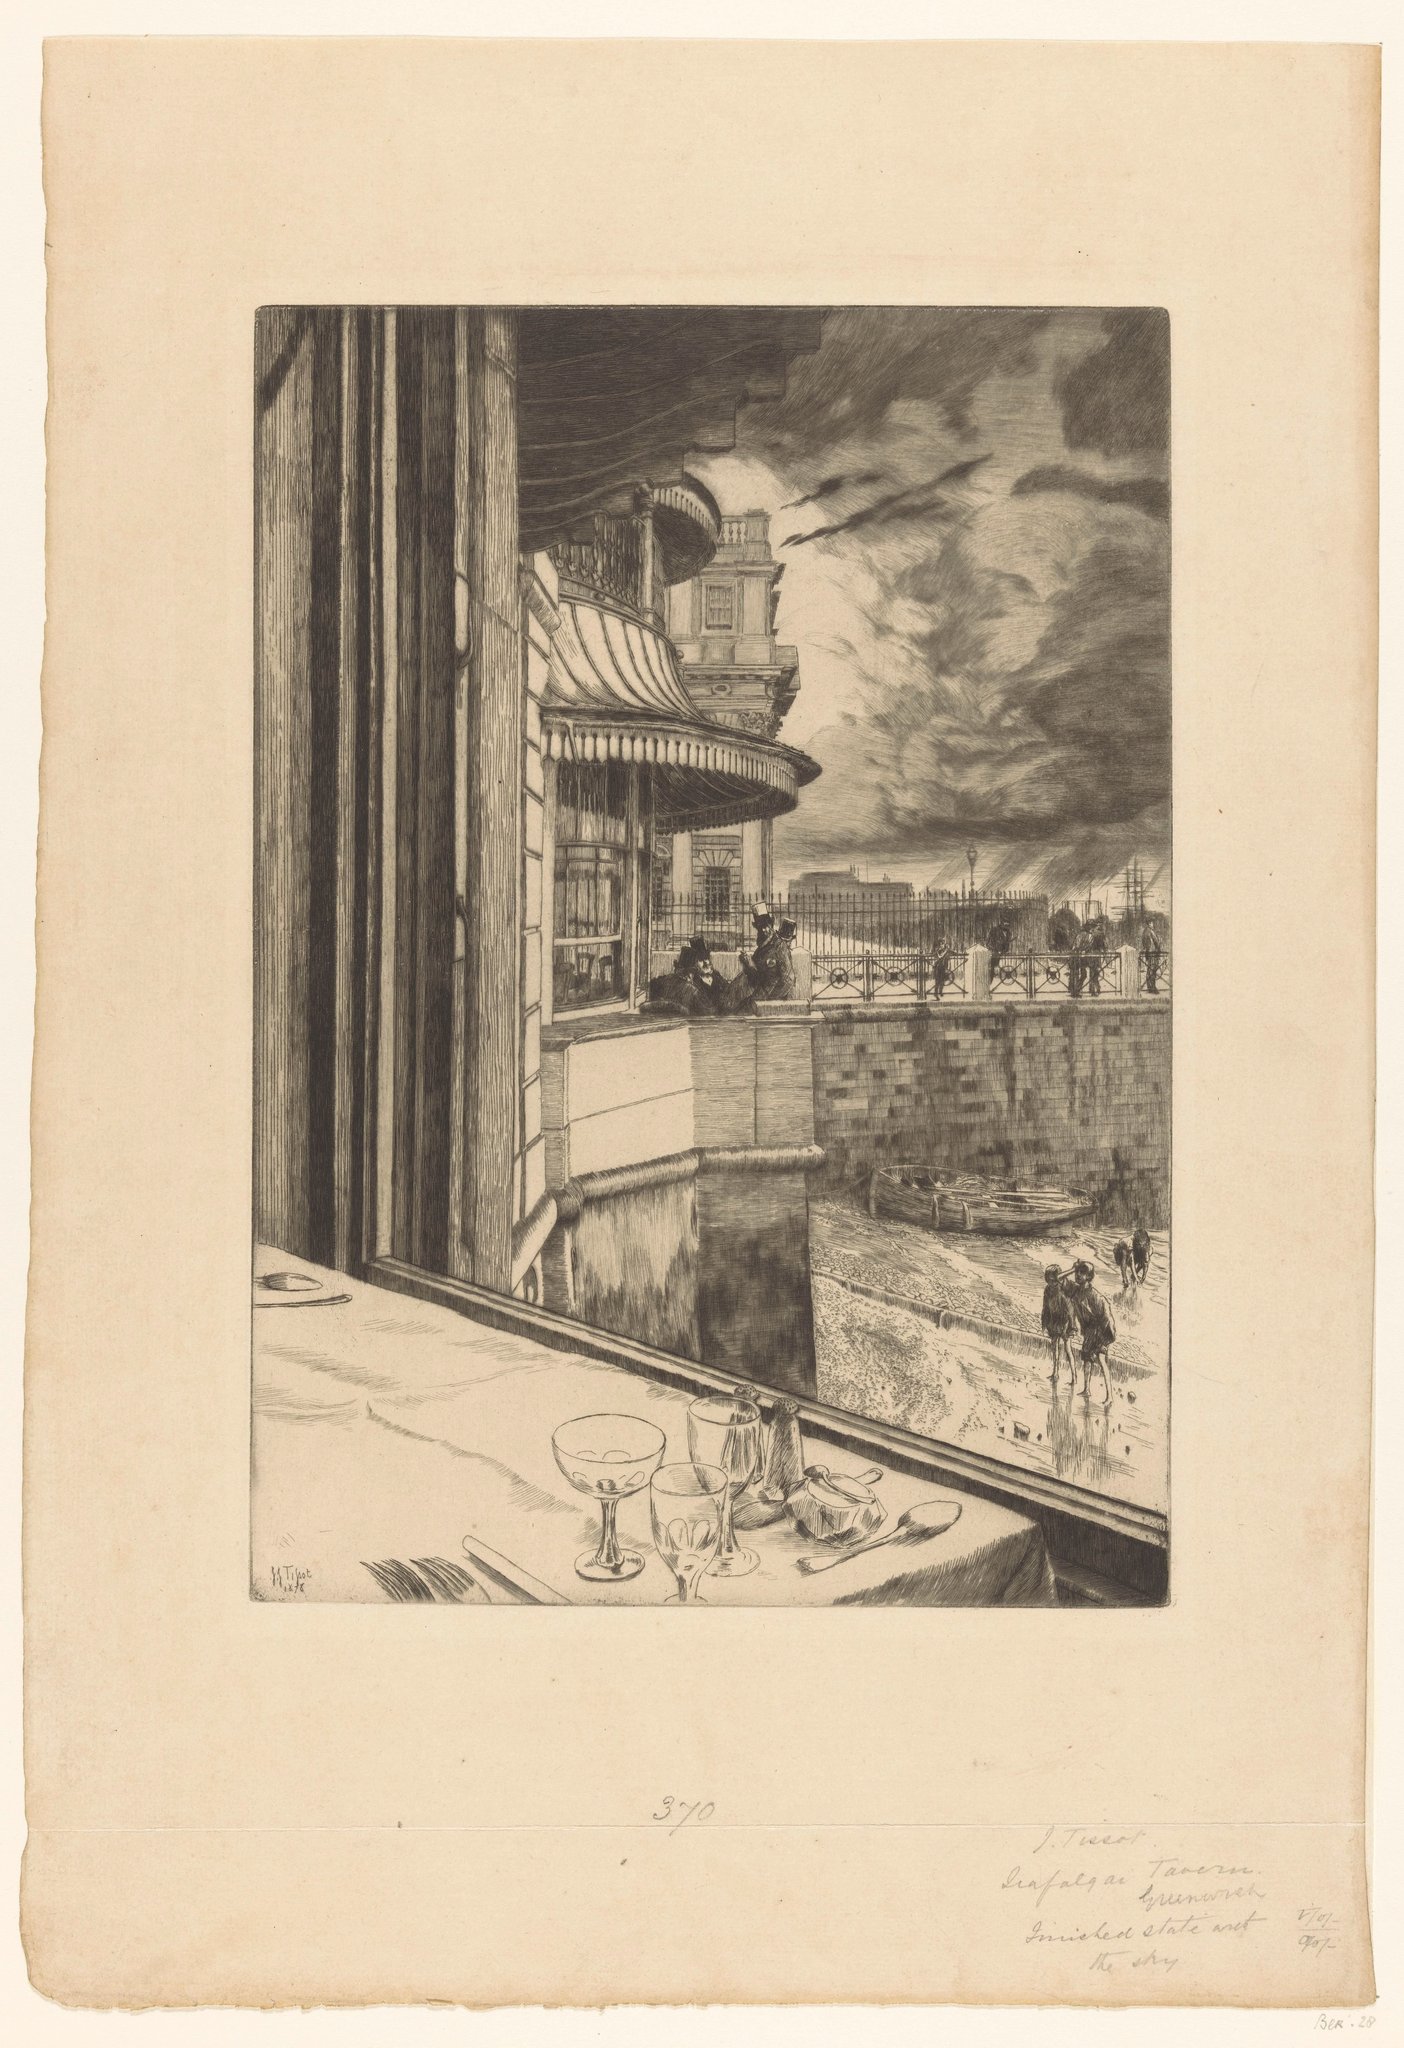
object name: print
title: Uitzicht vanuit het raam in Trafalgar Tavern te Greenwich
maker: james tissot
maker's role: draughtsman, print maker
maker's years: 1836-1902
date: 1878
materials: paper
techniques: drypoint, etching, intaglio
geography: london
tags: balcony, restaurant, laid table: table-ware, table-decoration, etc., beach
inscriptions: collector's mark: Lugt 2228, inscription: ‘I q[...] fecit at Par{...} 14/2/13 JN. ME 479’, number: ‘370’, collector's mark: Lugt 2760, inscription: ‘J. Tissot. Trafalger Tavern Greenwich. Finished state with the sky.’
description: Een gedekte tafel aan een raam met uitzicht op een strand met drie kinderen, een balkon met vier deftig geklede heren en op de achtergrond een boulevard.